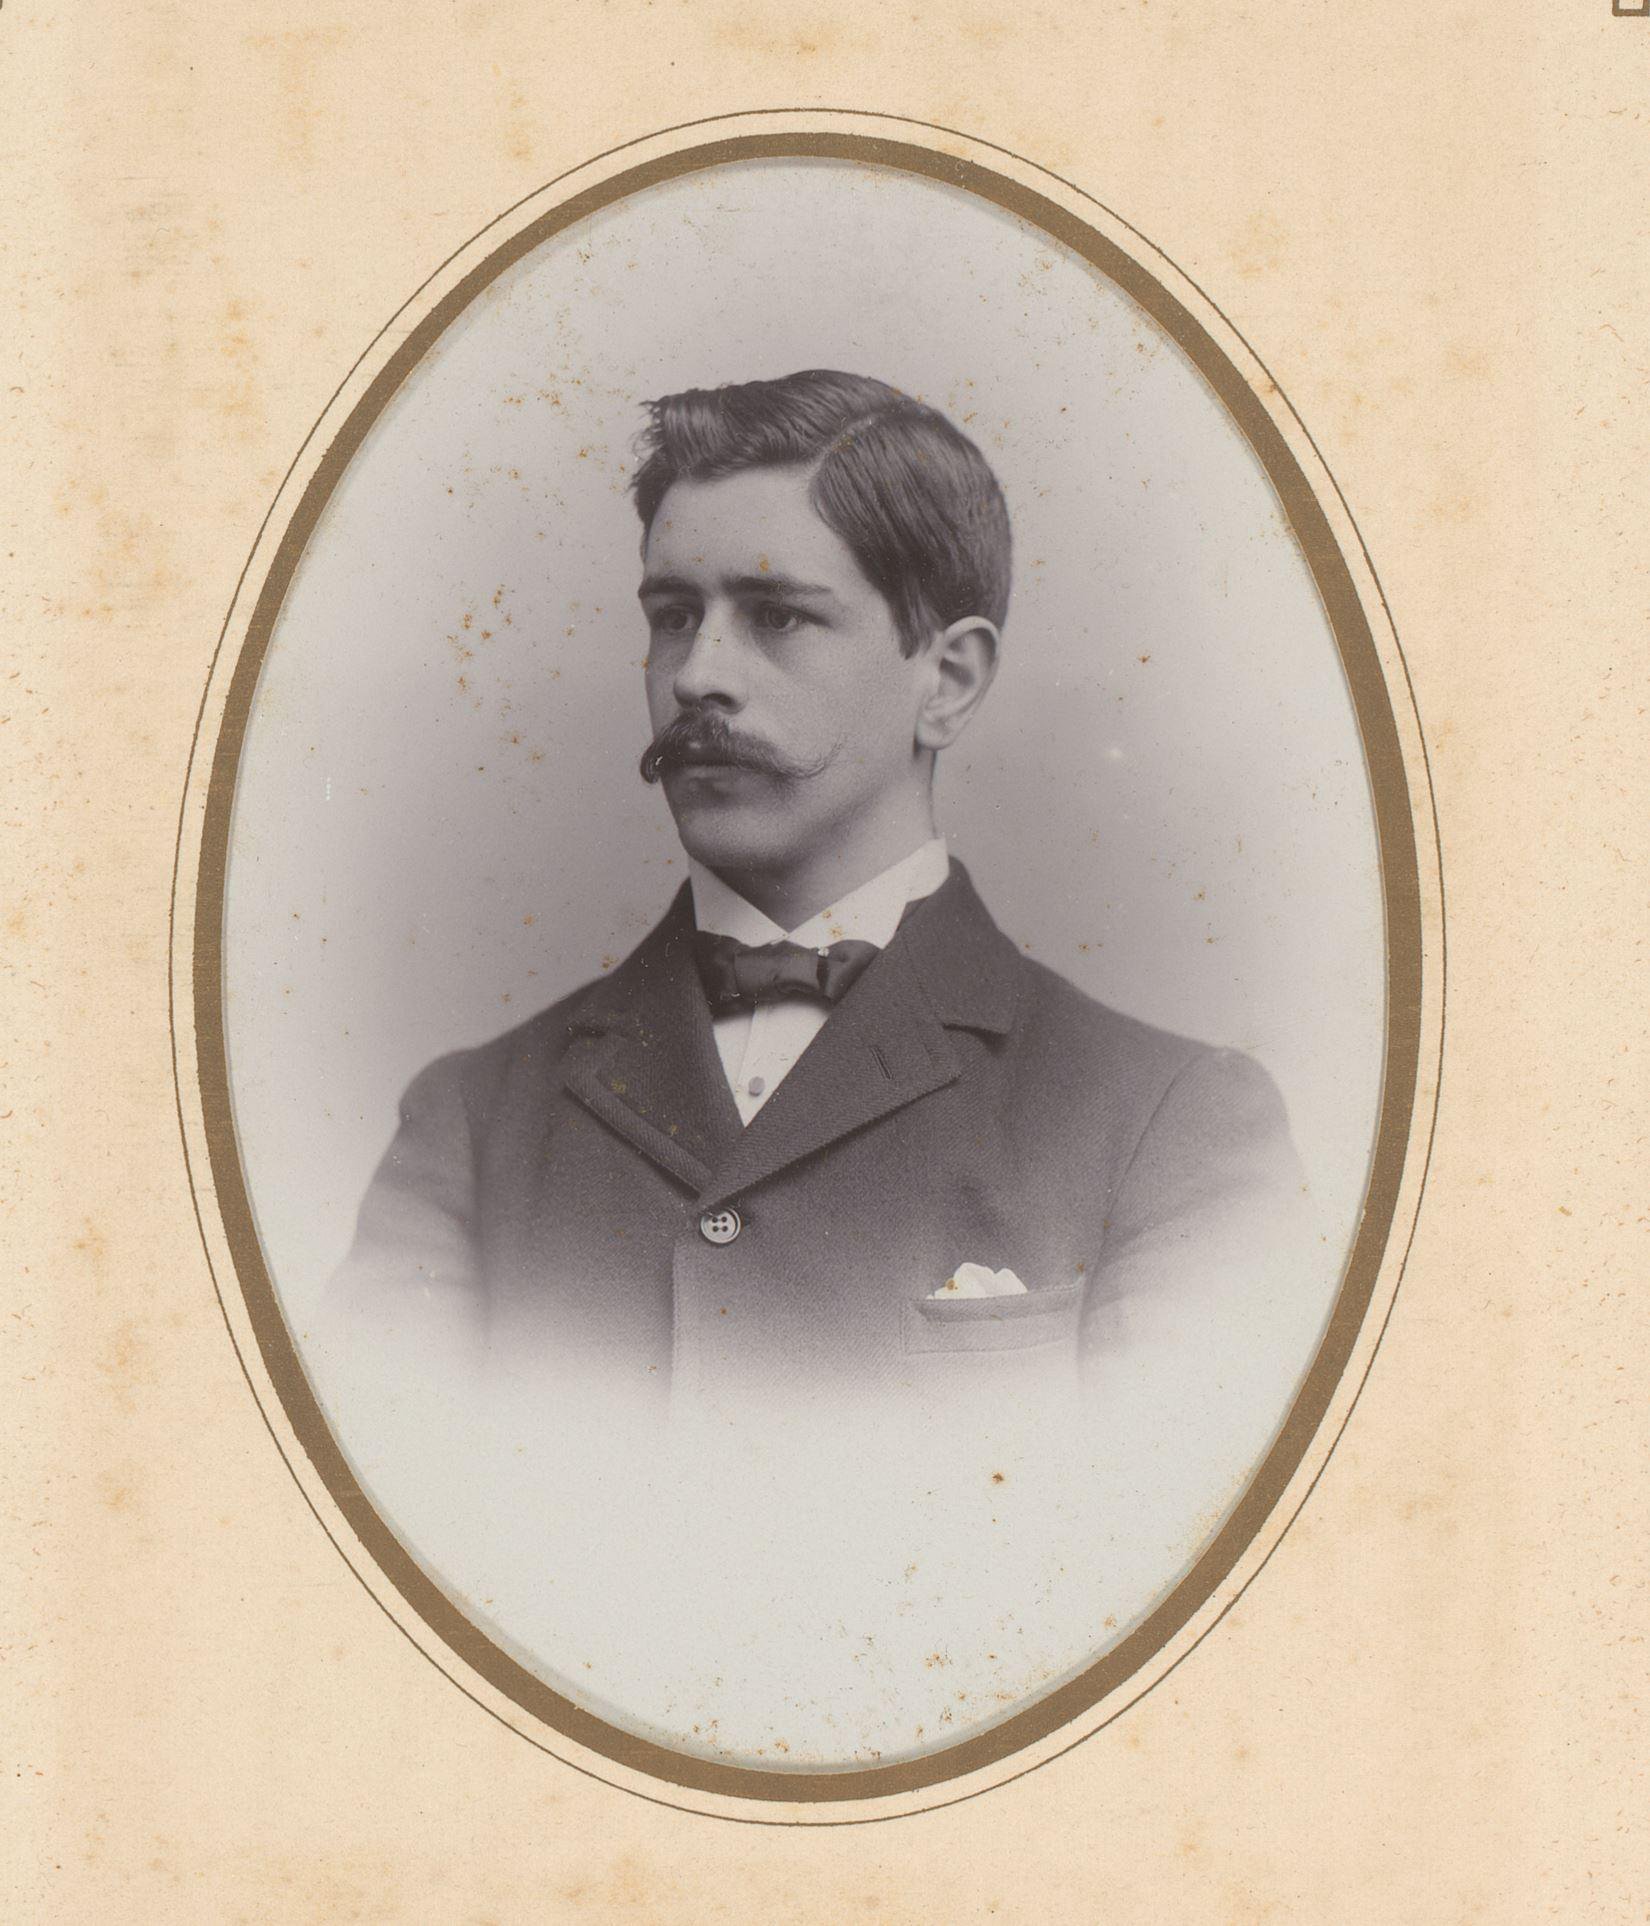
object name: album leaf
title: Portret van een man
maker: antonius joannes van der stok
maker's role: fotograaf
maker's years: 1862-1941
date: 1880-1920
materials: cardboard, photographic support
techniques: collodion silver print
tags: moustache, adult man, historical persons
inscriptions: inscription: ‘Van der Stok Leiden’